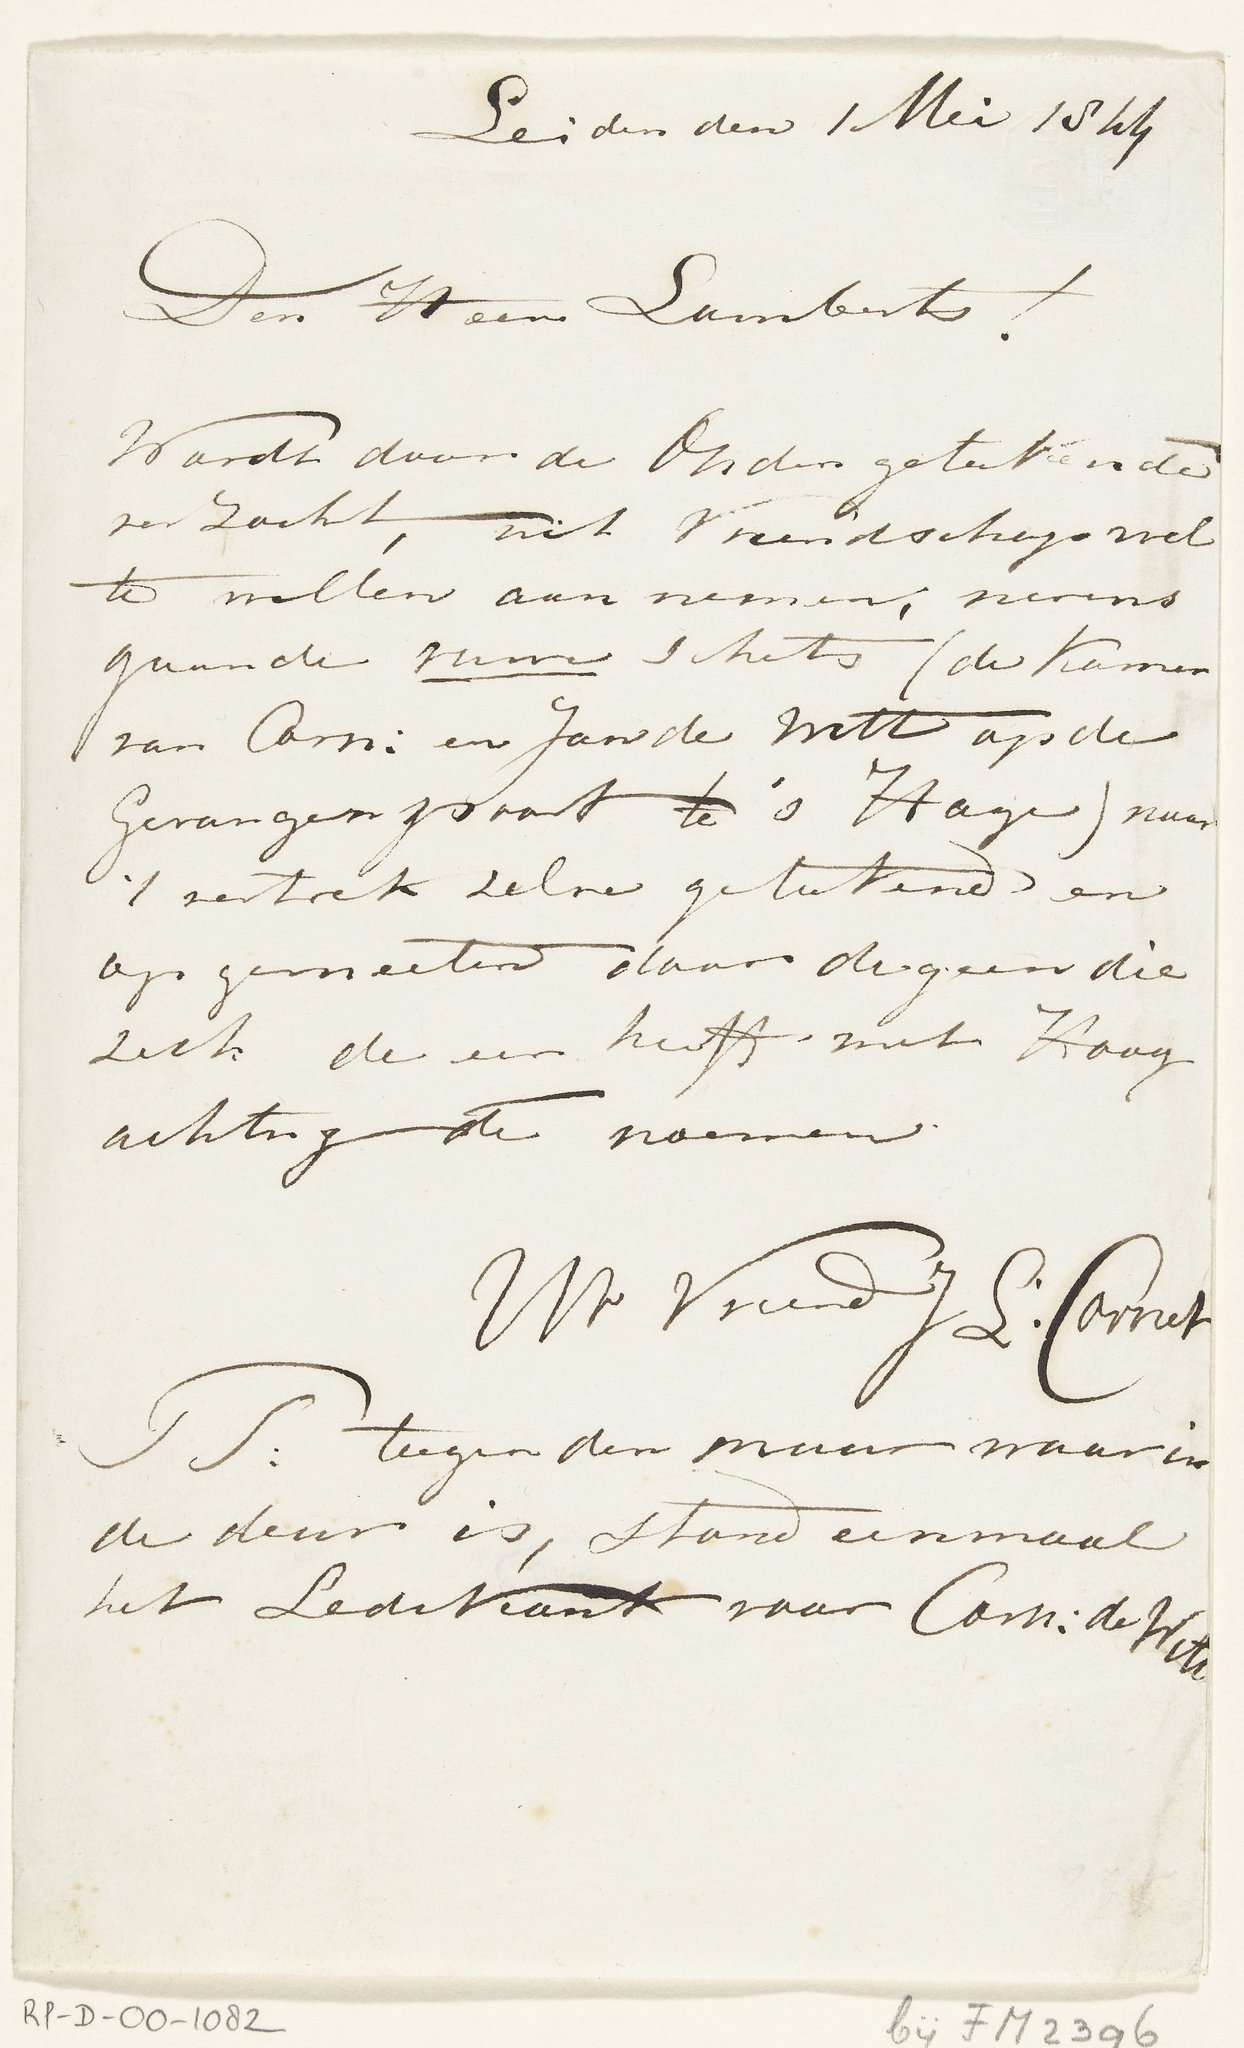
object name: letter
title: Brief van J.L. Cornet aan dhr. Lamberts over de tekening van de kamer van Cornelis de Witt in de Gevangenpoort, 1844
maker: jacobus ludovicus cornet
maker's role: draughtsman, print maker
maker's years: 1815-1882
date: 1844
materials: paper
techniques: writing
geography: leiden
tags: dordrecht, cornelis de witt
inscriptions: collector's mark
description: Brief van de tekenaar J.L. Cornet aan dhr. Lamberts aangaande de tekening, een ruwe schets, van de kamer van Cornelis de Witt in de Gevangenpoort, Leiden 1 mei 1844.